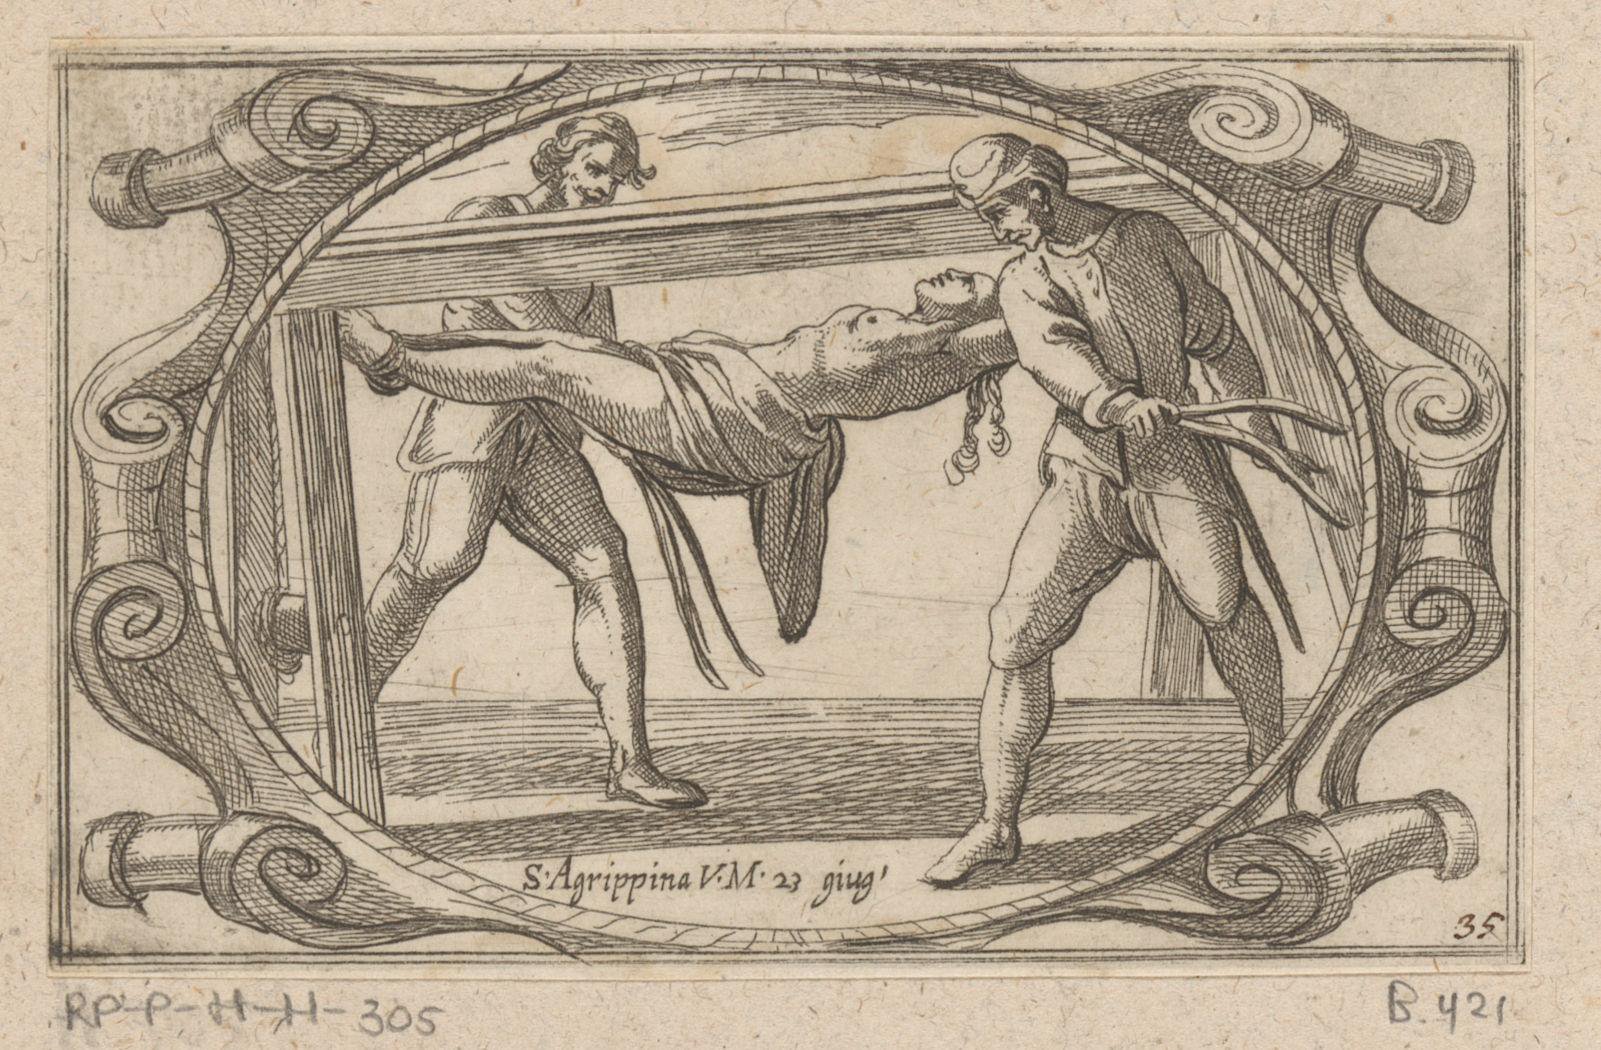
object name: print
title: H. Agrippina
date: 1565-1630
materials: paper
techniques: etching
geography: rome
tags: martyr(s) (often with palm-branches) - qq - female martyr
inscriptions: number: ‘35’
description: Deze prent maakt deel uit van een reeks van 73 prenten (+ titelprent) met voorstellingen van Romeinse martelaressen.